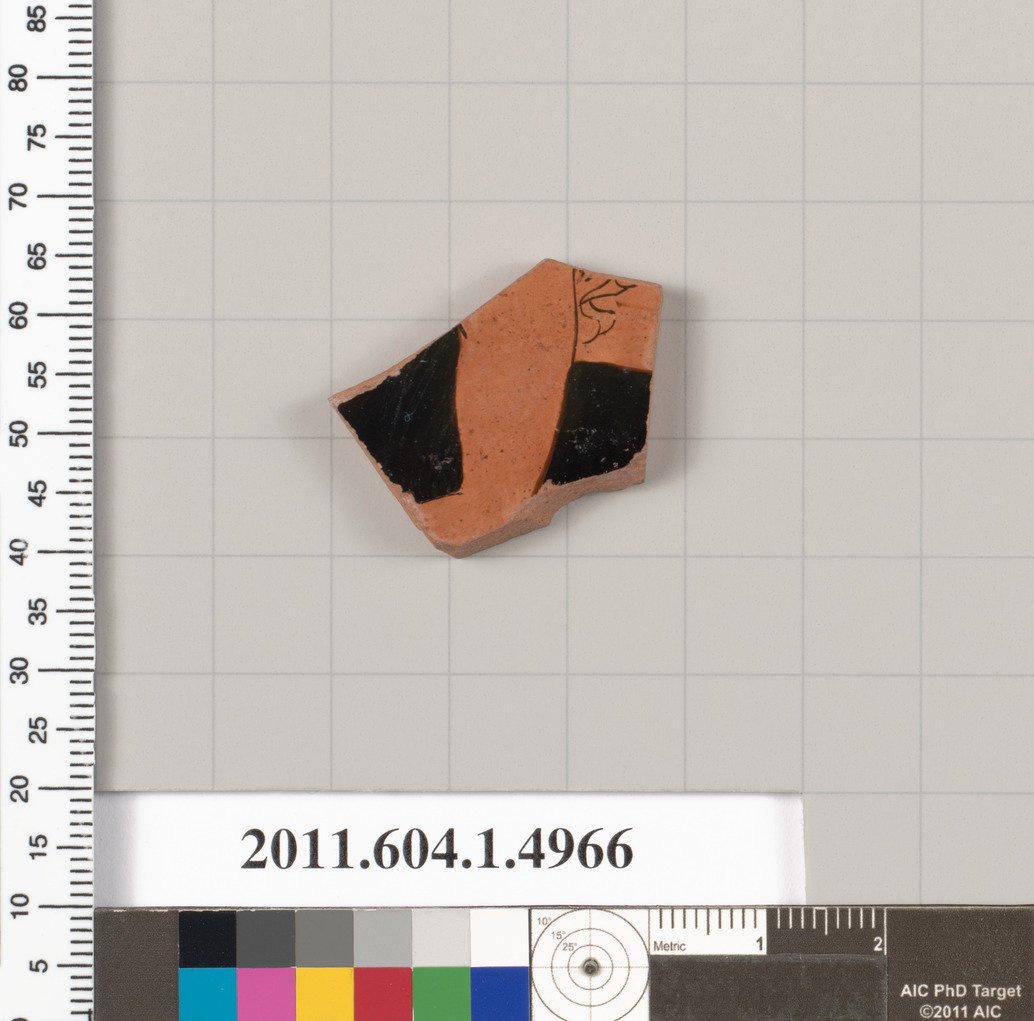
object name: kylix fragment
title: Terracotta fragment of a kylix (drinking cup)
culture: greek, attic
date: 475-451 BCE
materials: terracotta